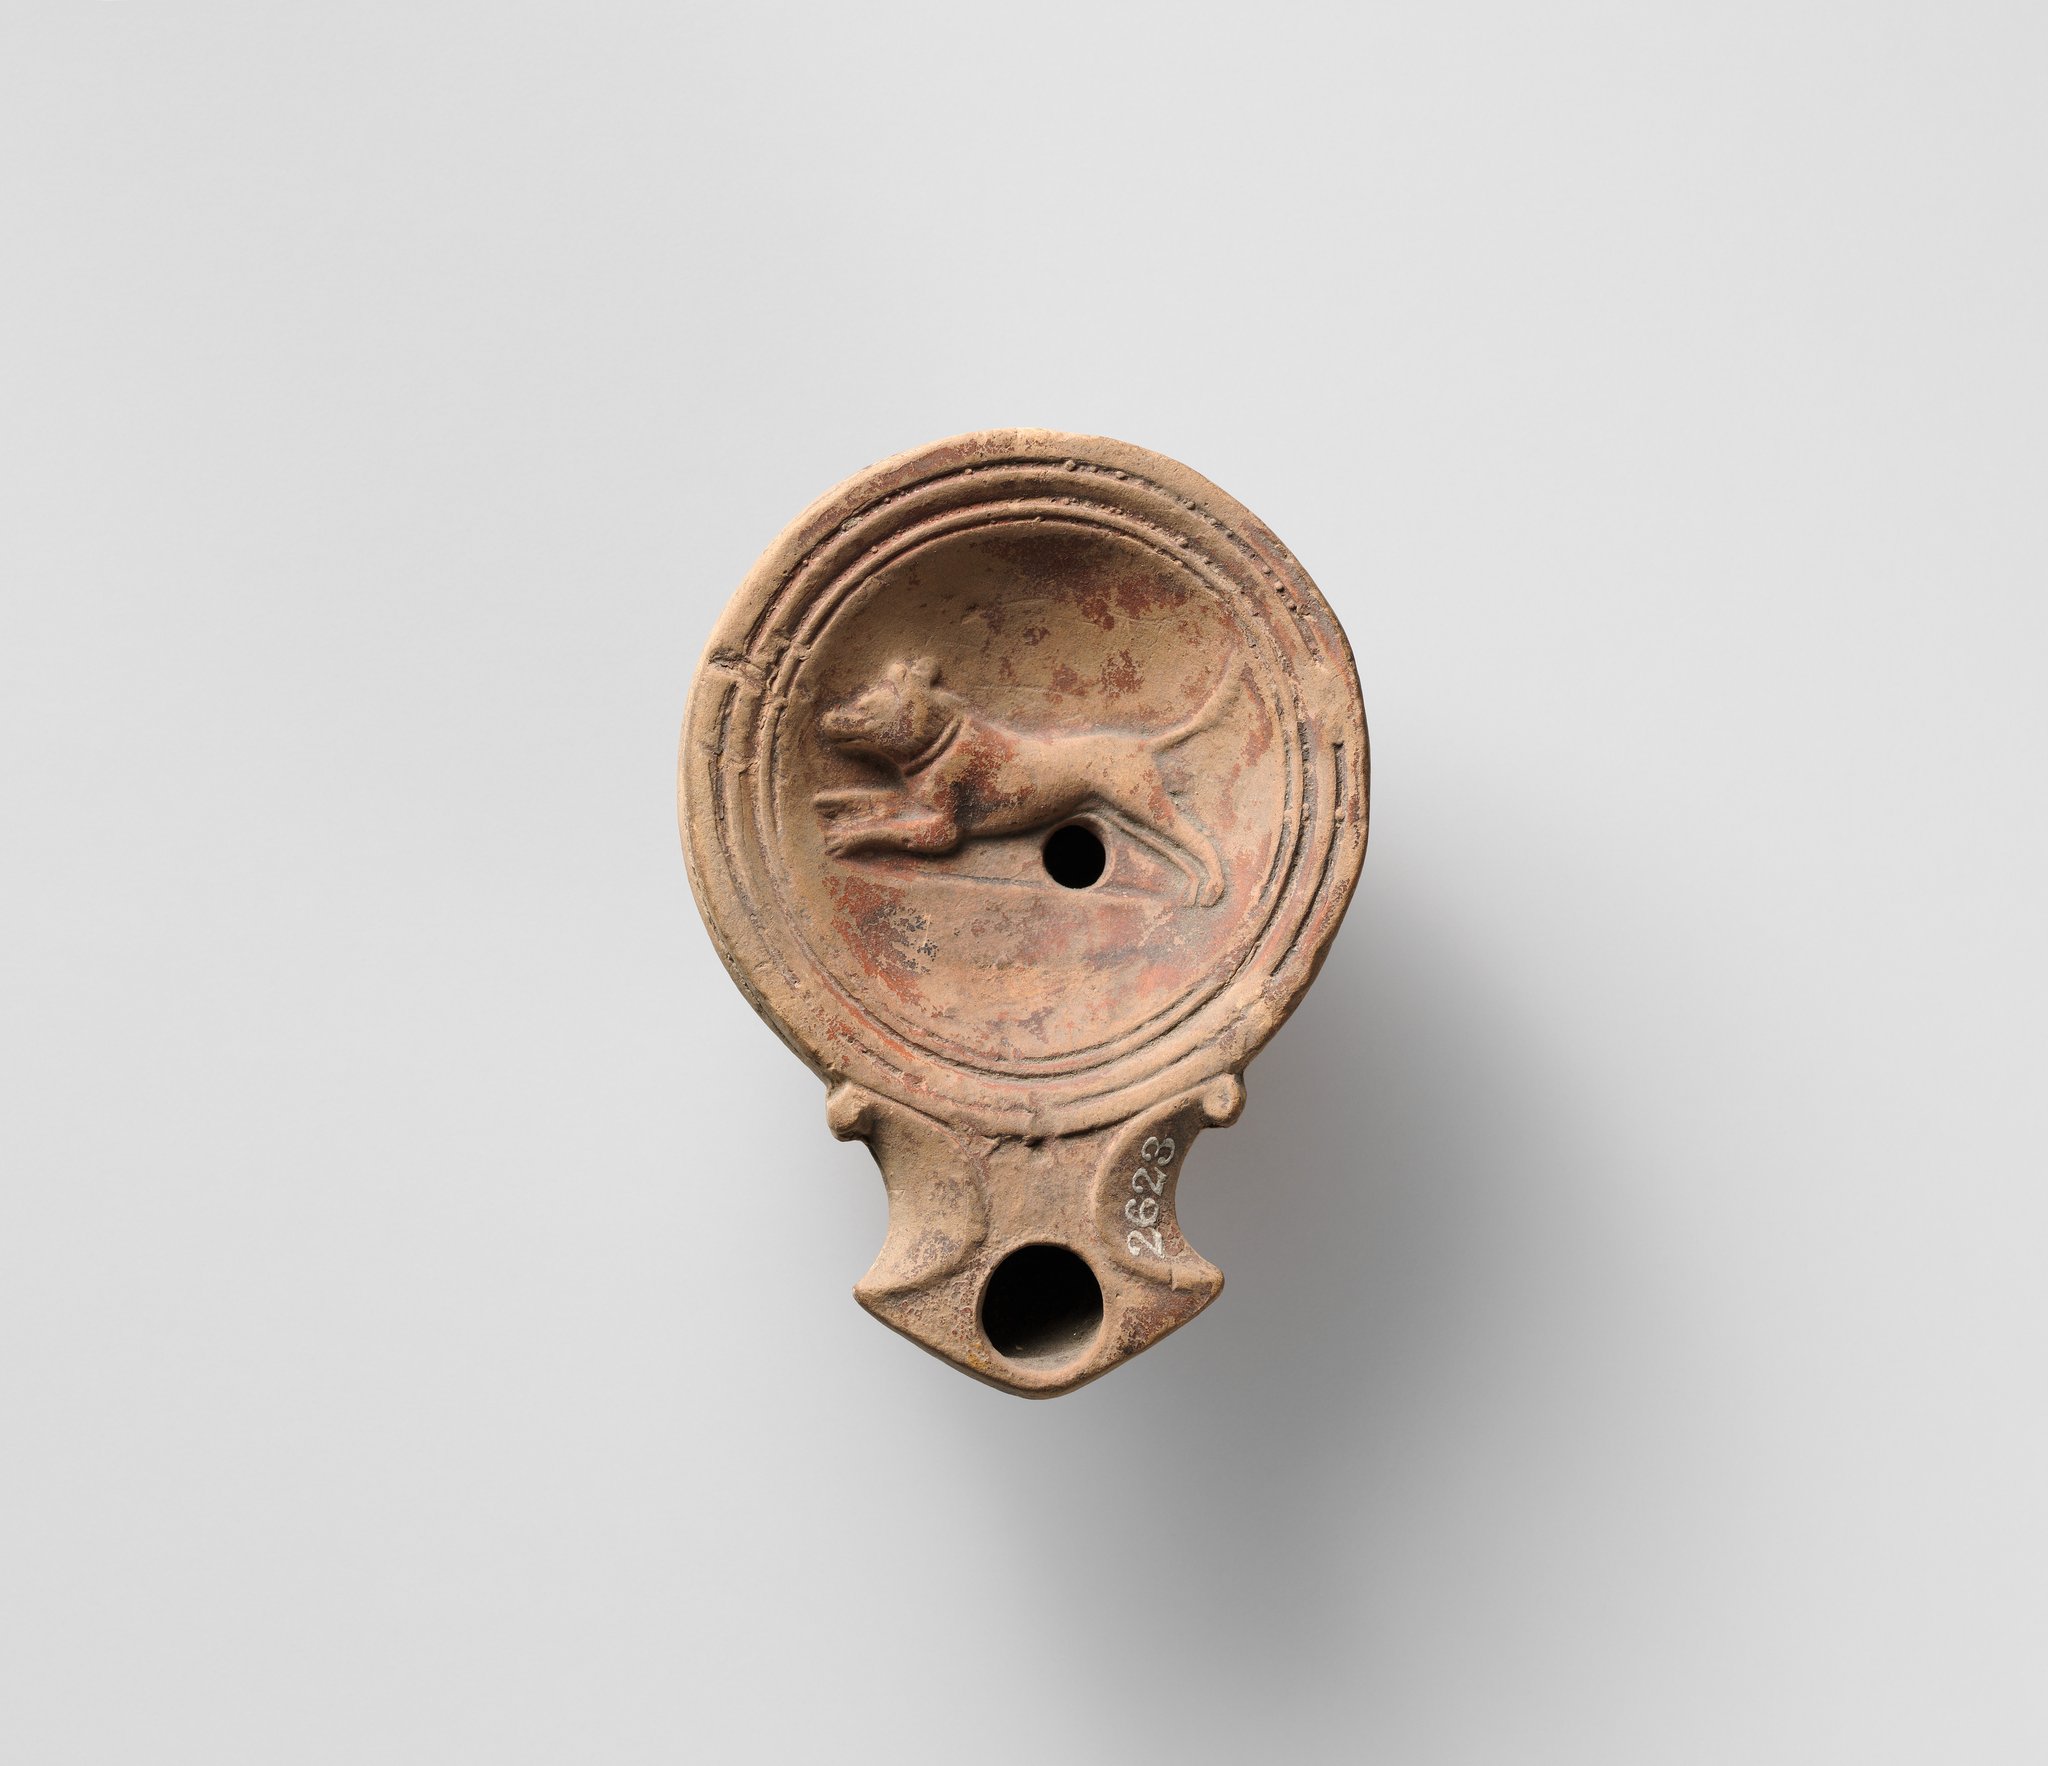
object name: lamp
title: Terracotta oil lamp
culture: roman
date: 100 BCE-100 CE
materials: terracotta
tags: dogs